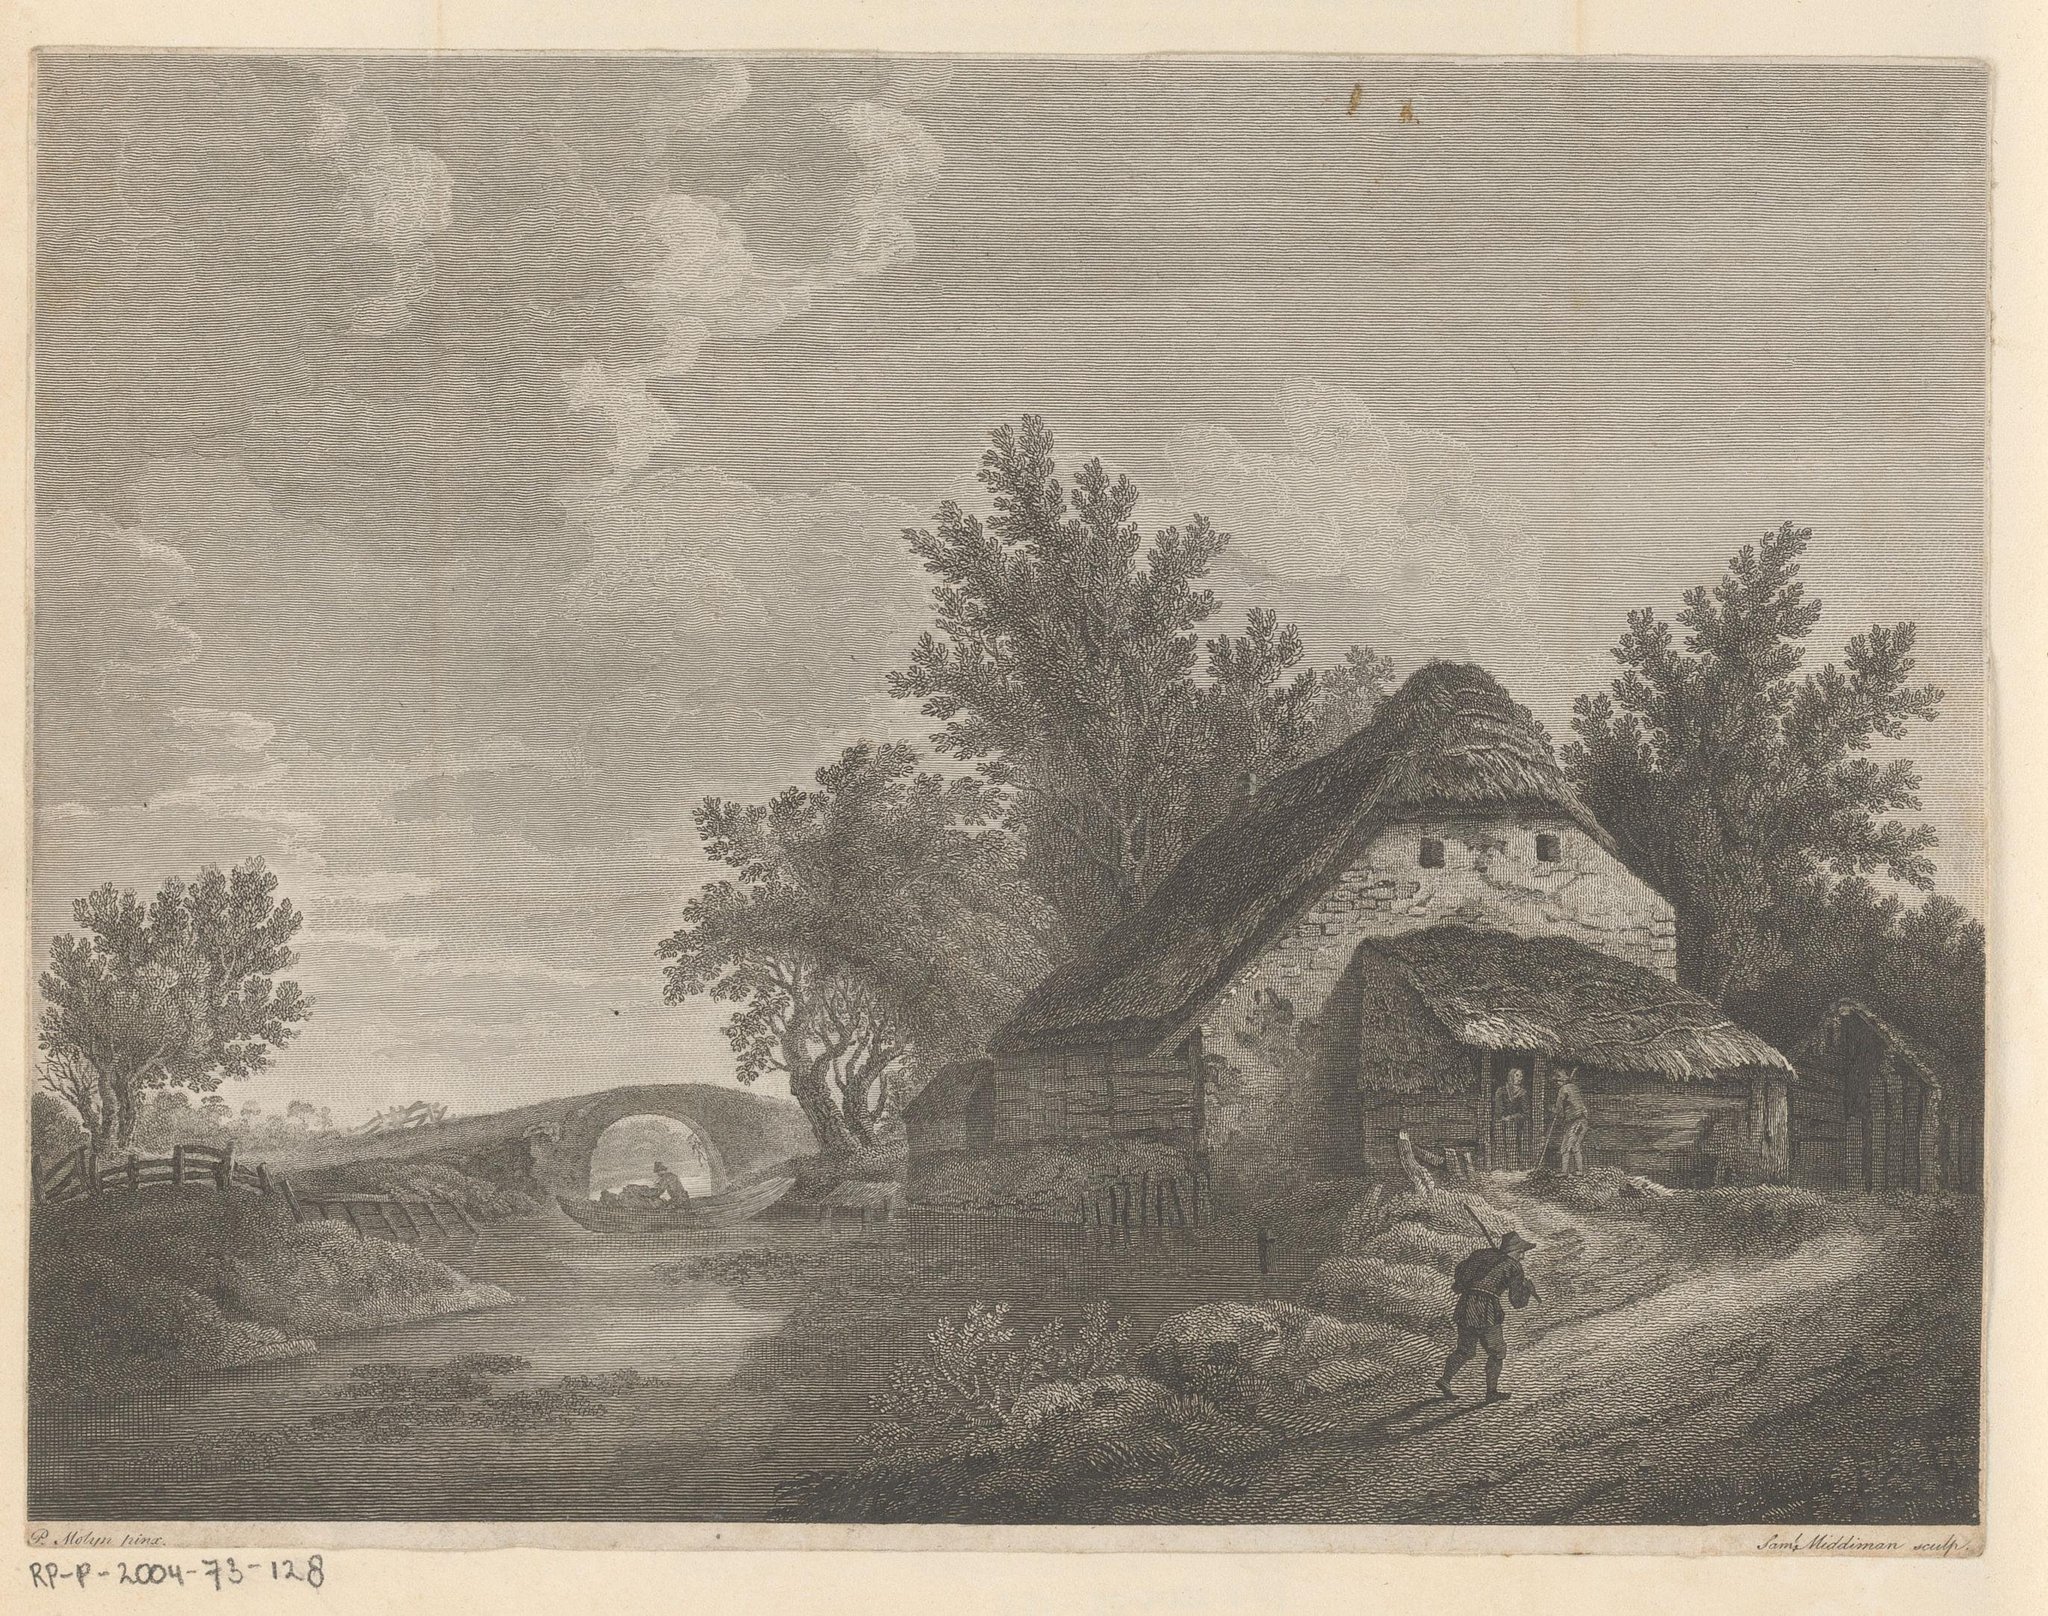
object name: print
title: Boerderij naast een beek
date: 1760-1831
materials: paper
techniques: engraving, etching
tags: rural housing, e.g. country-house, villa, cottage, brook (+ landscape with figures, staffage)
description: De samensteller heeft deze prent in het album geplakt als illustratie bij: Pilkington, Matthew en Johann Heinrich Füssli. A dictionary of painters, from the revival of the art to the present period. 4 dln. Londen: John Crowder, 1805, dl. 2, p. 343.